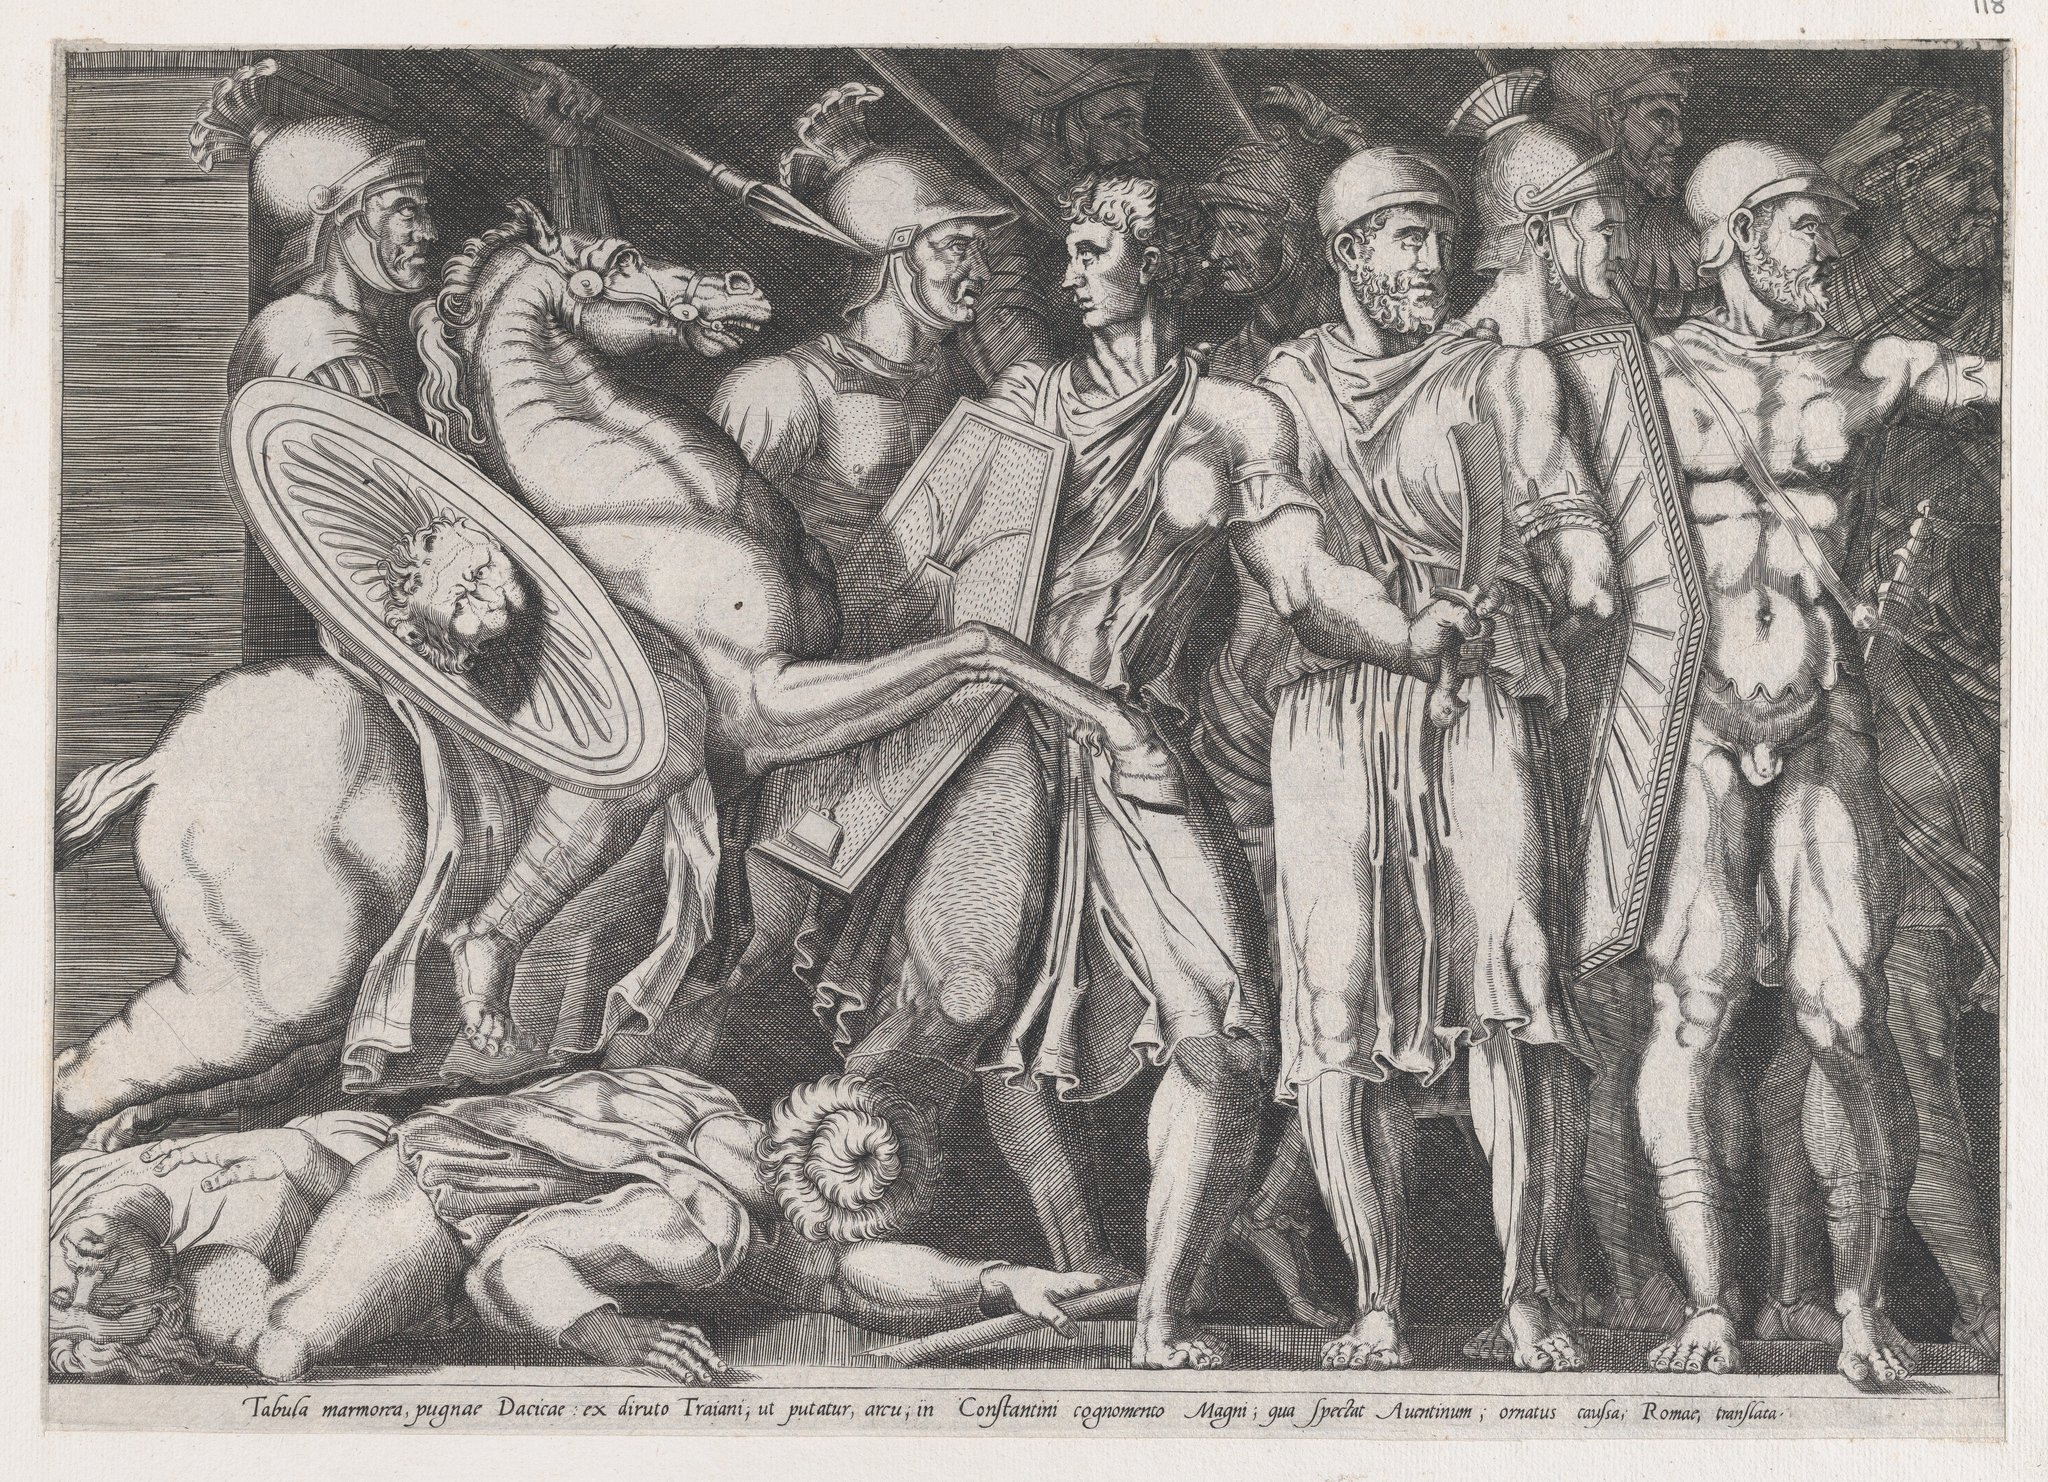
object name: print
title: Trajan Fighting the Dacians, from "Speculum Romanae Magnificentiae"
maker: marco dente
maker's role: artist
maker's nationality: italian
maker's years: 1515-1527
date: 1501-1600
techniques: engraving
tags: soldiers,shields,weapons,male nudes,horses